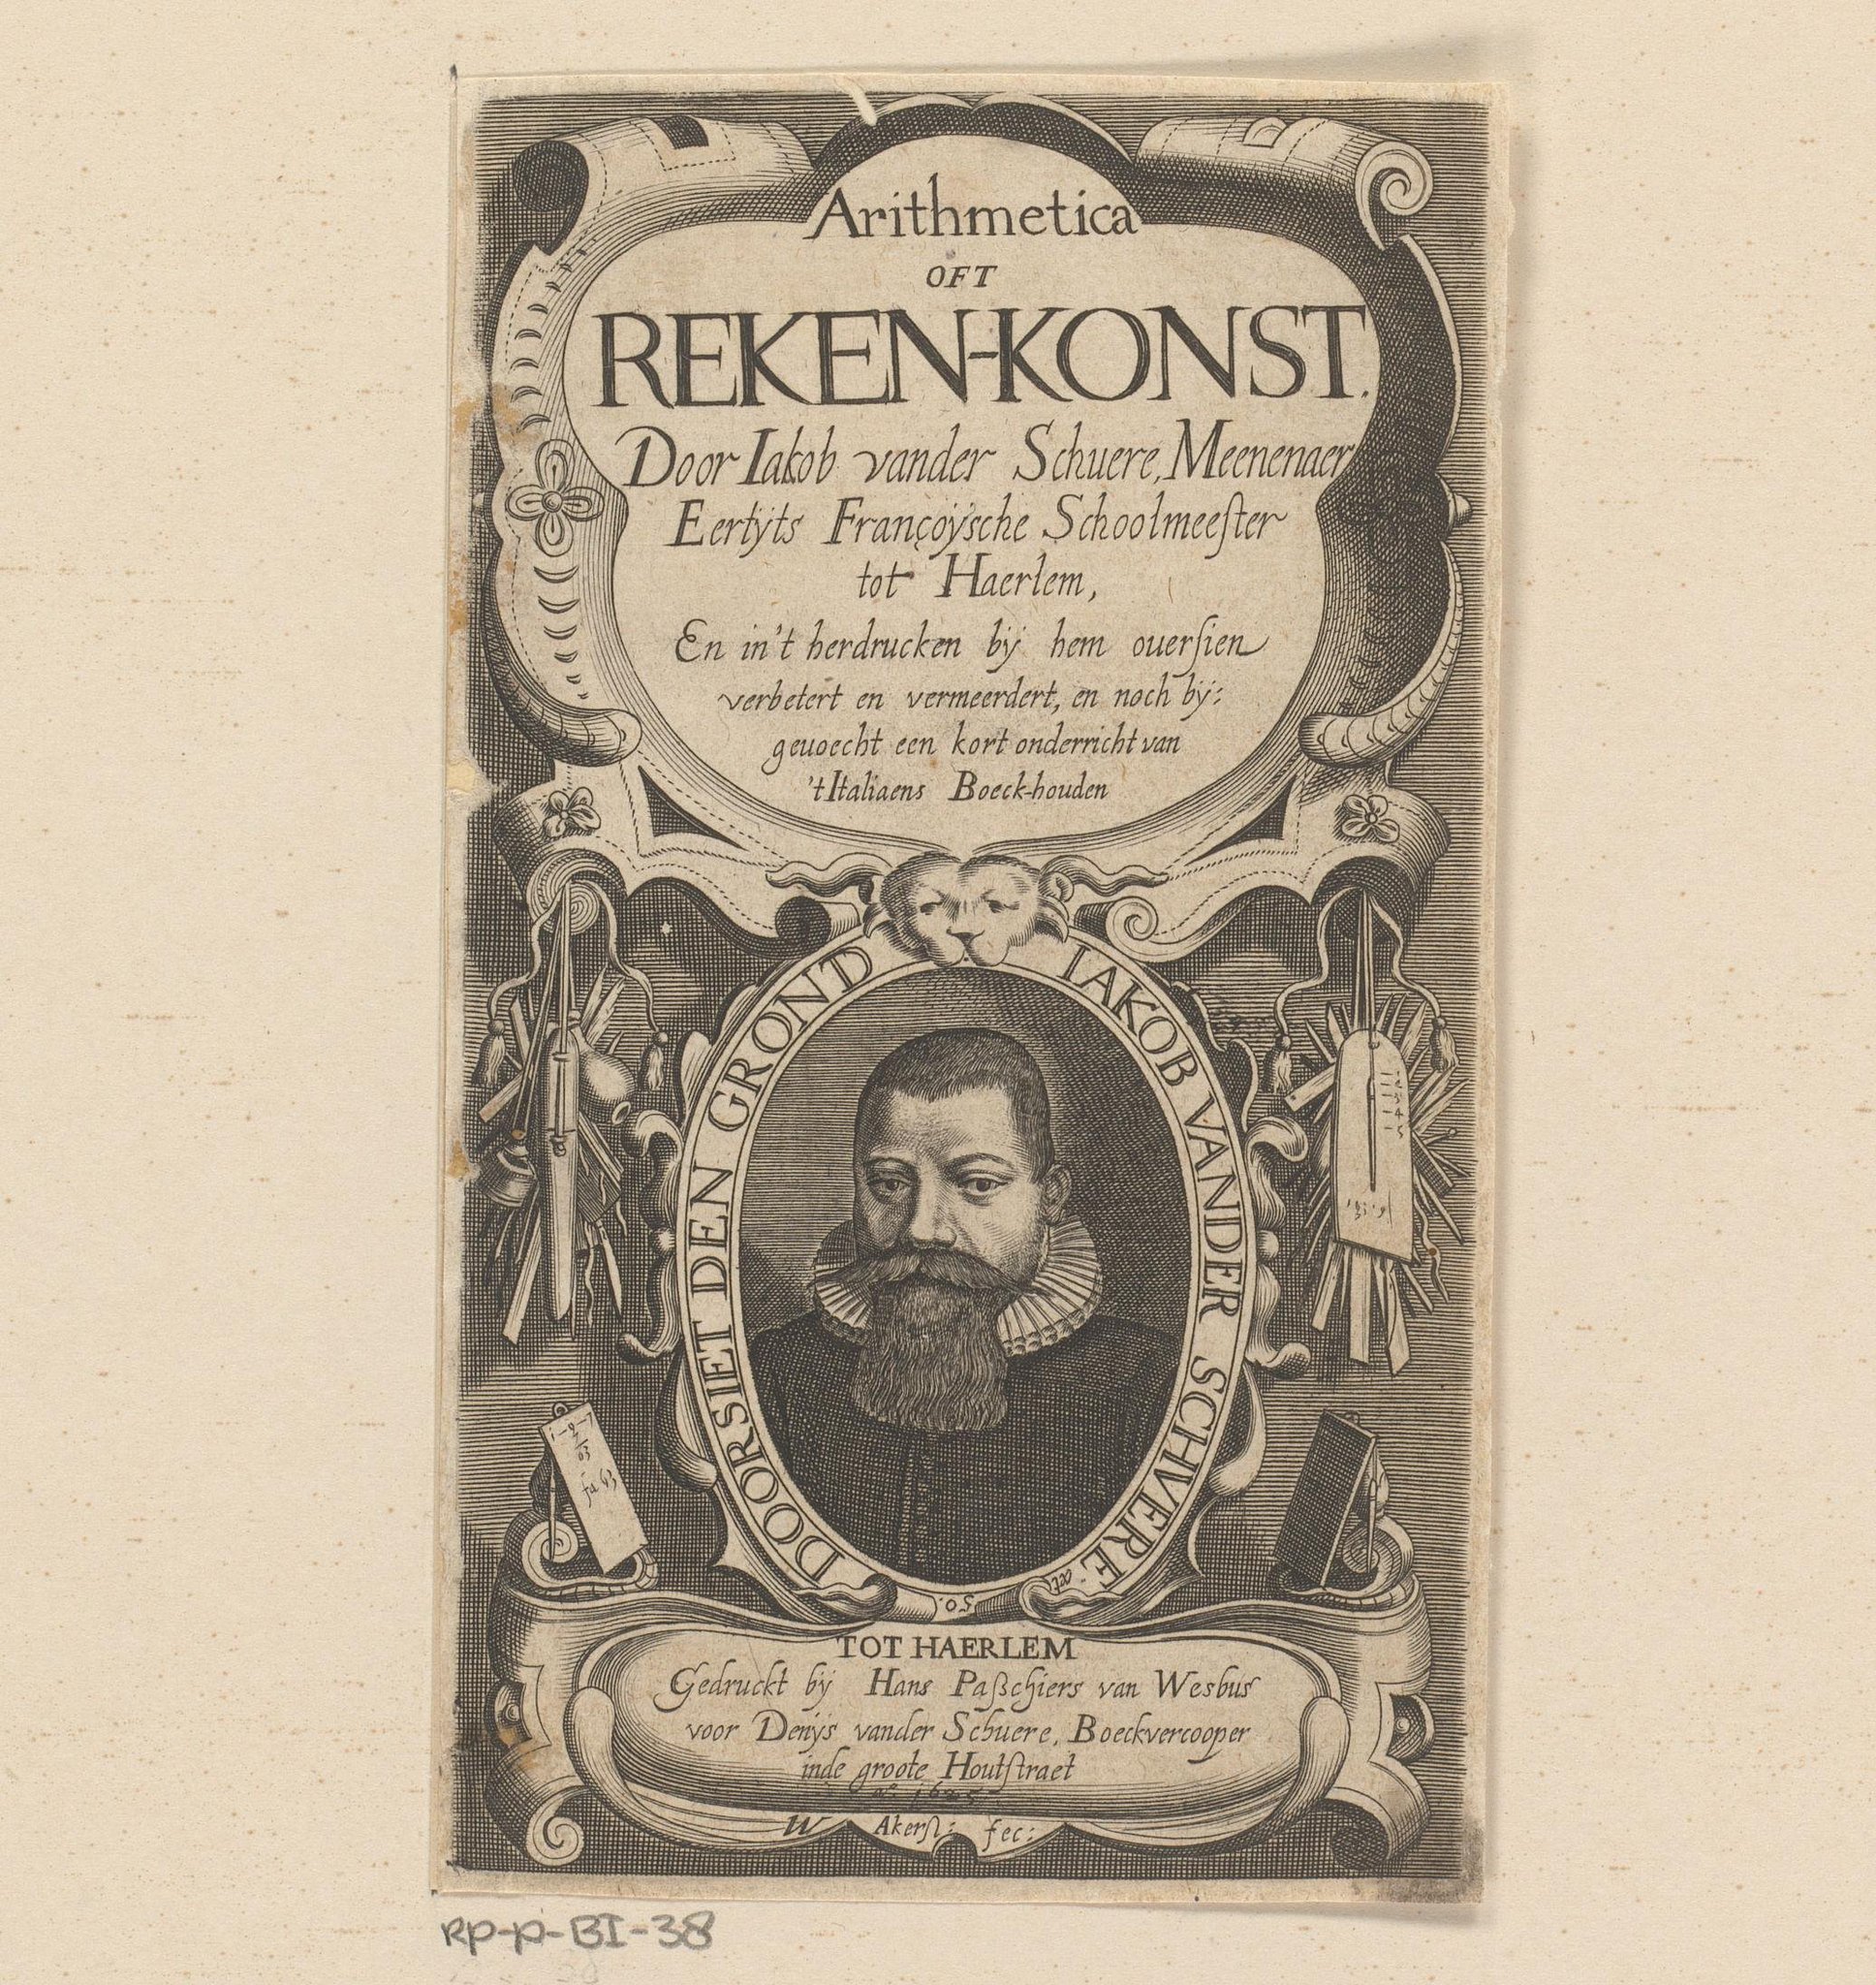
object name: print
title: Portret van Jacob van der Schuere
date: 1625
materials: paper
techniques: engraving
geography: haarlem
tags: historical persons, portrait of a writer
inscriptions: collector's mark: Lugt 2228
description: Met de titel van het boek, een zevenregelig bovenschrift in het Nederlands en tekst in het Nederlands rondom het portret.